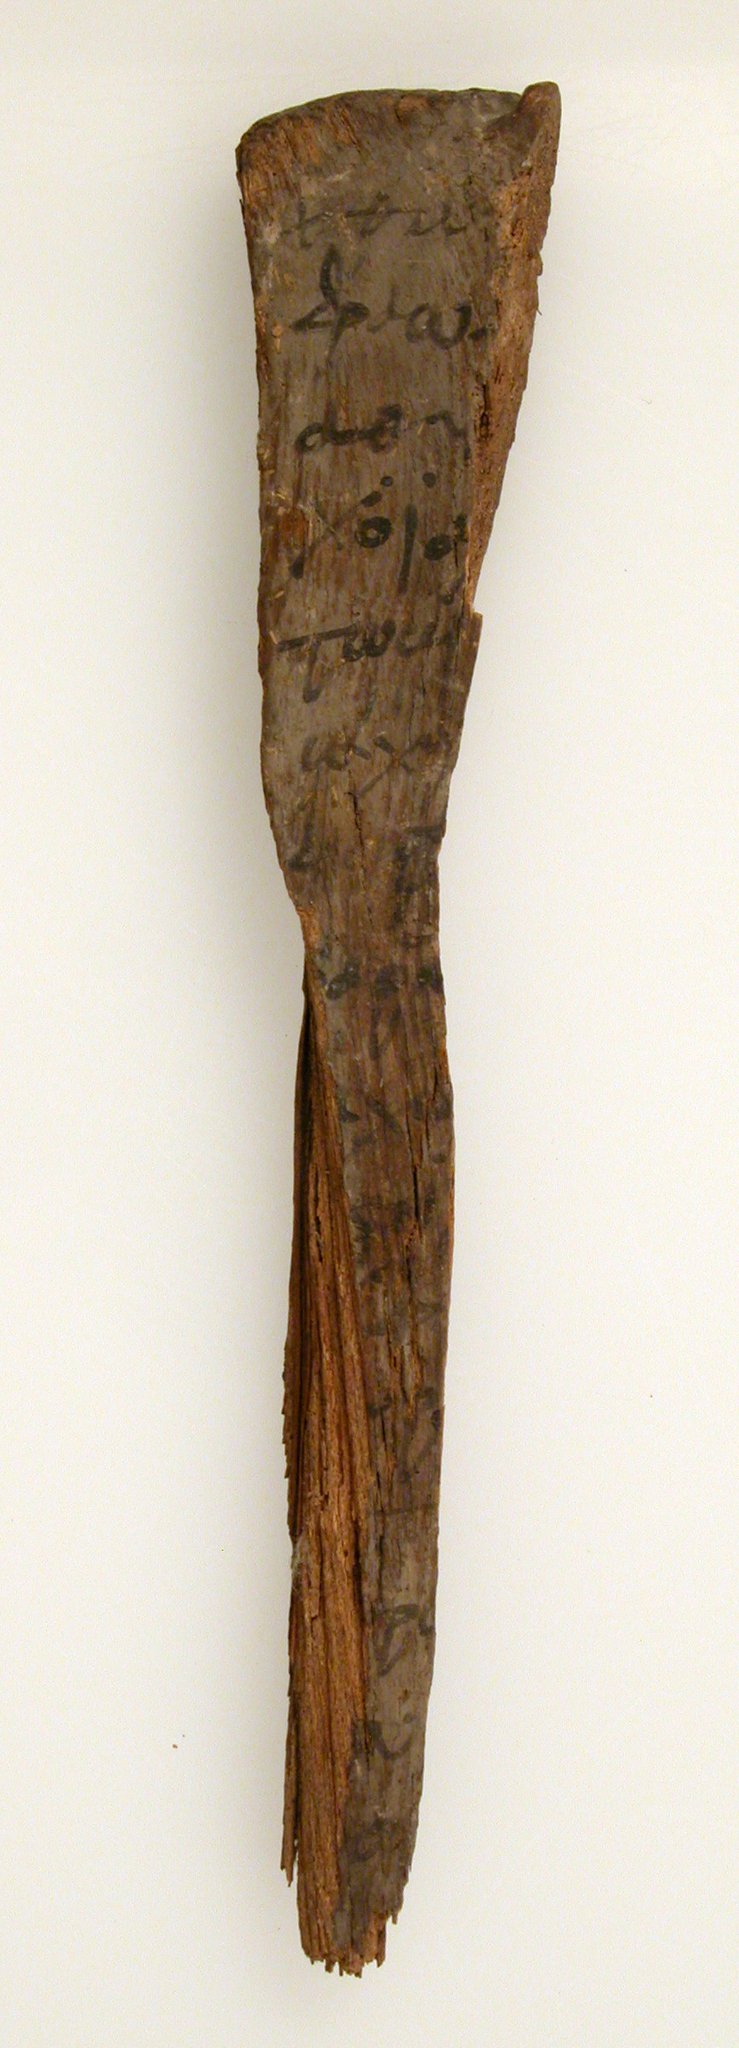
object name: ostrakon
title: Ostrakon with a List of Coptic Months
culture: coptic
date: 600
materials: ink, wood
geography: egypt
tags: documents